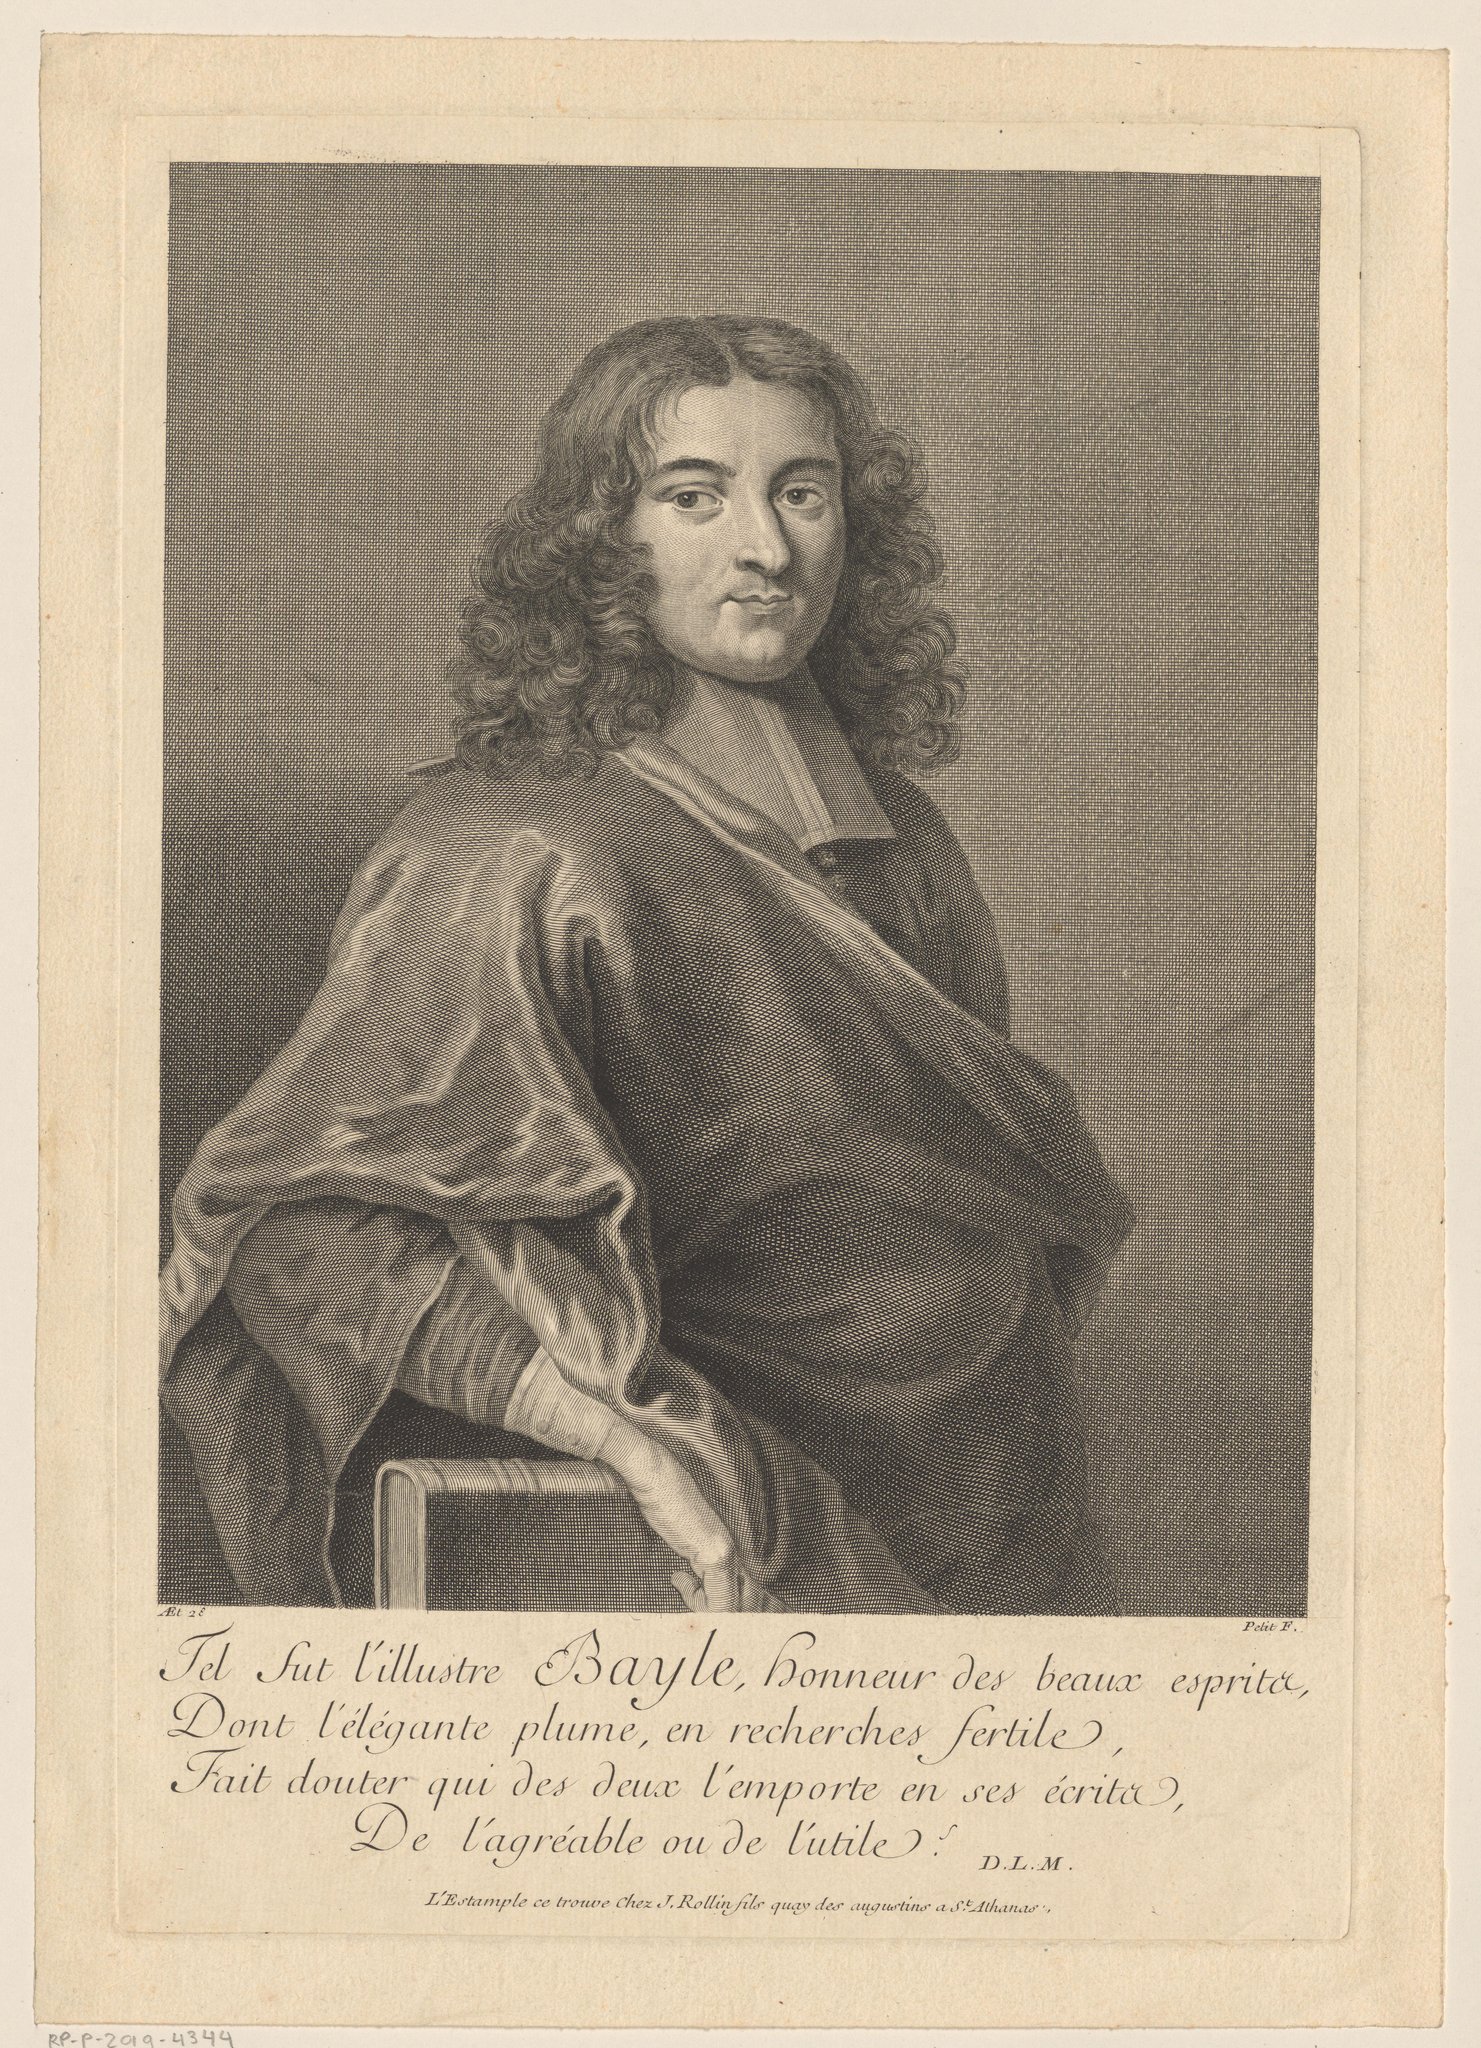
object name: print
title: Portret van Pierre Bayle op 28-jarige leeftijd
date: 1736-1751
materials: paper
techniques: engraving, etching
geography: paris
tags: rotterdam, historical persons, book